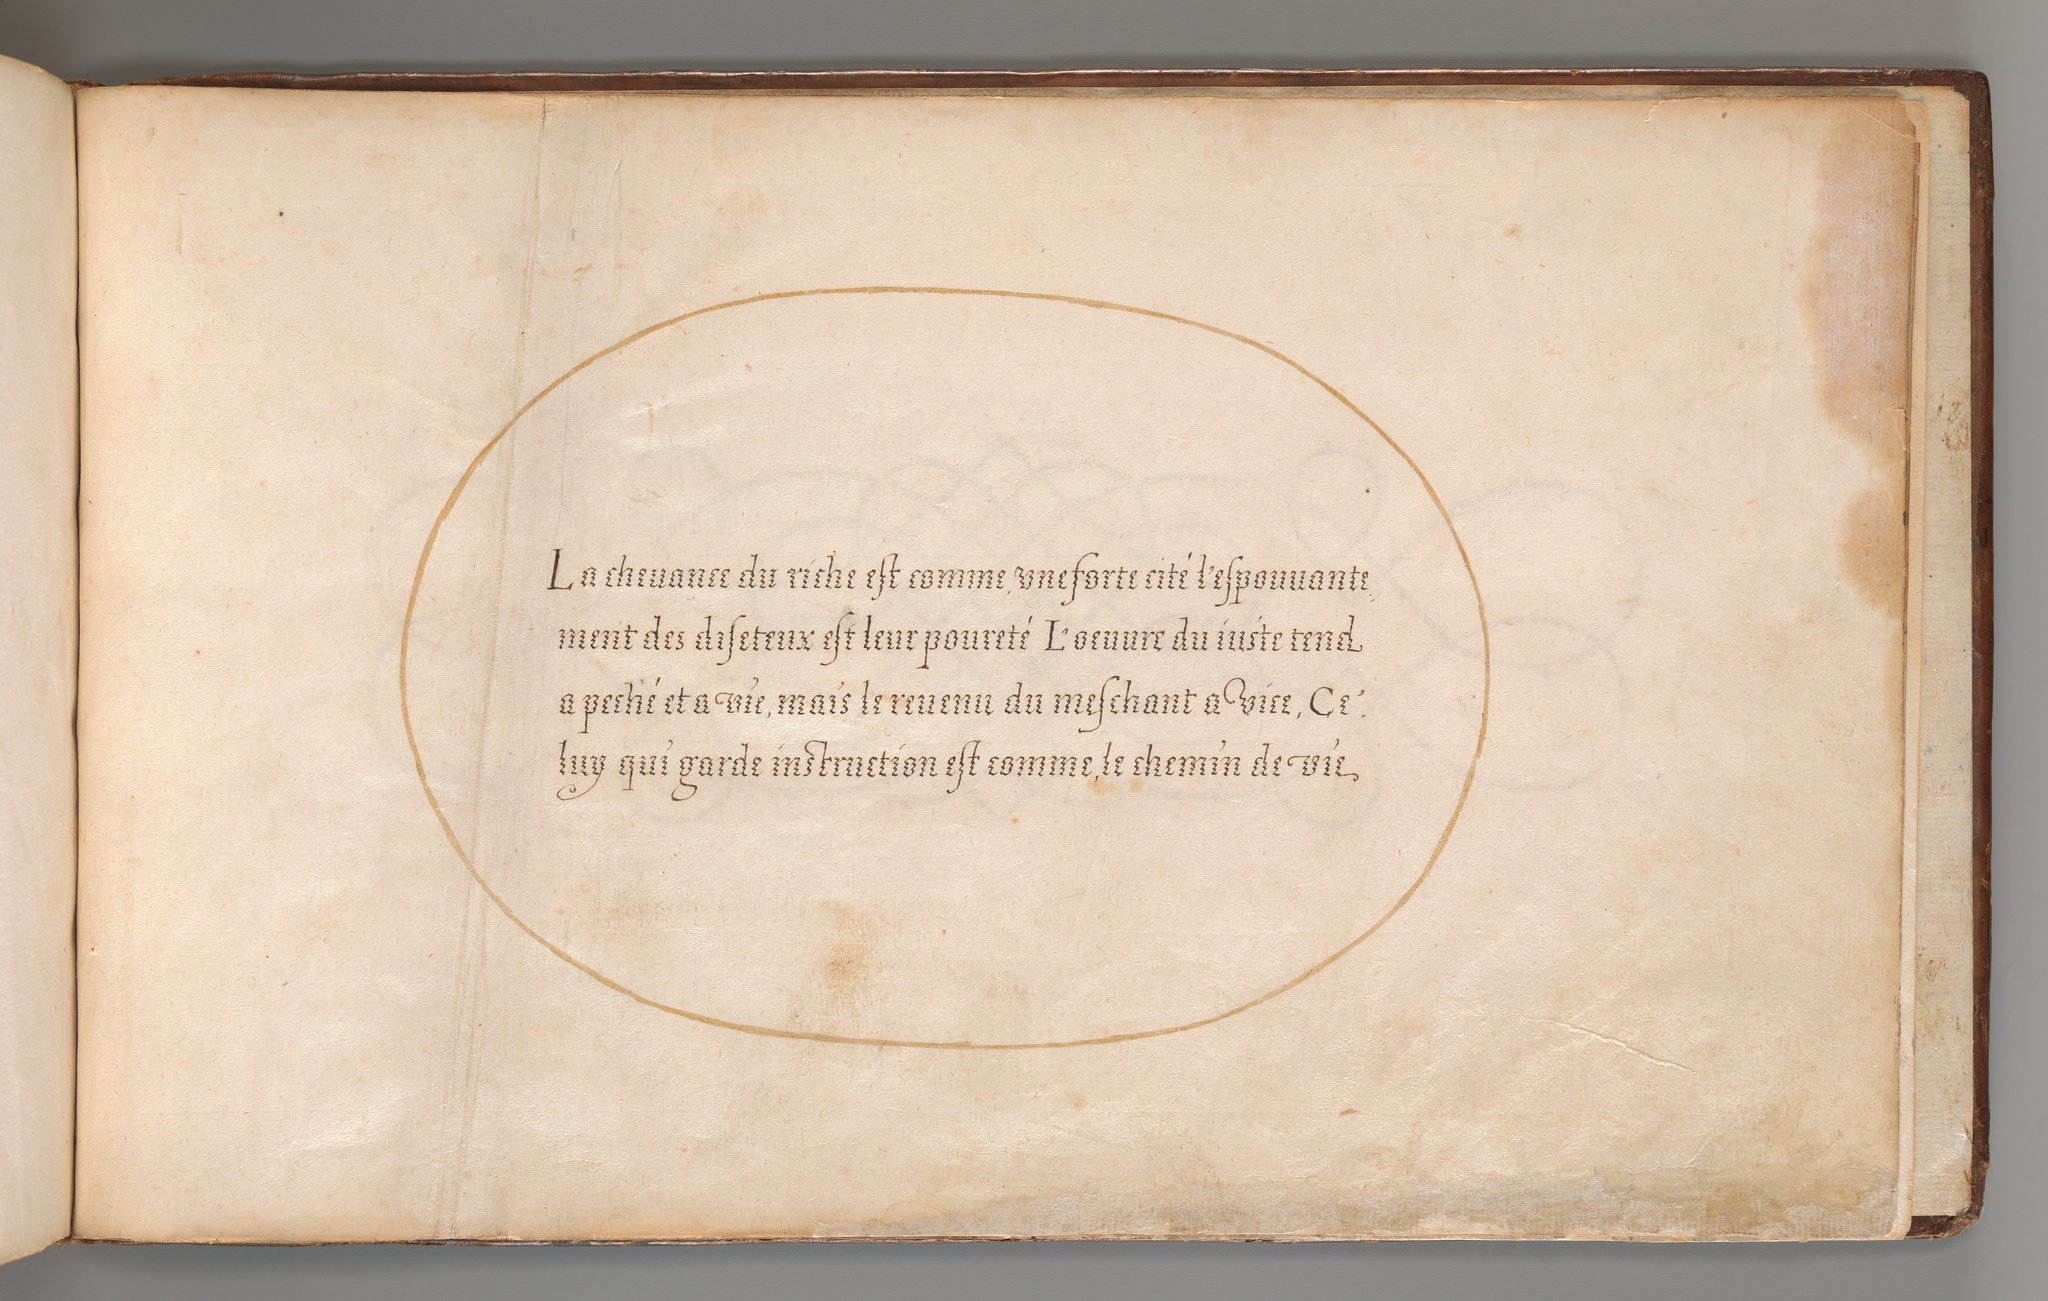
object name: album print ornament architecture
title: Calligraphic Exercise in French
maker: Anonymous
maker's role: artist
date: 1601-1633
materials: ink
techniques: pen